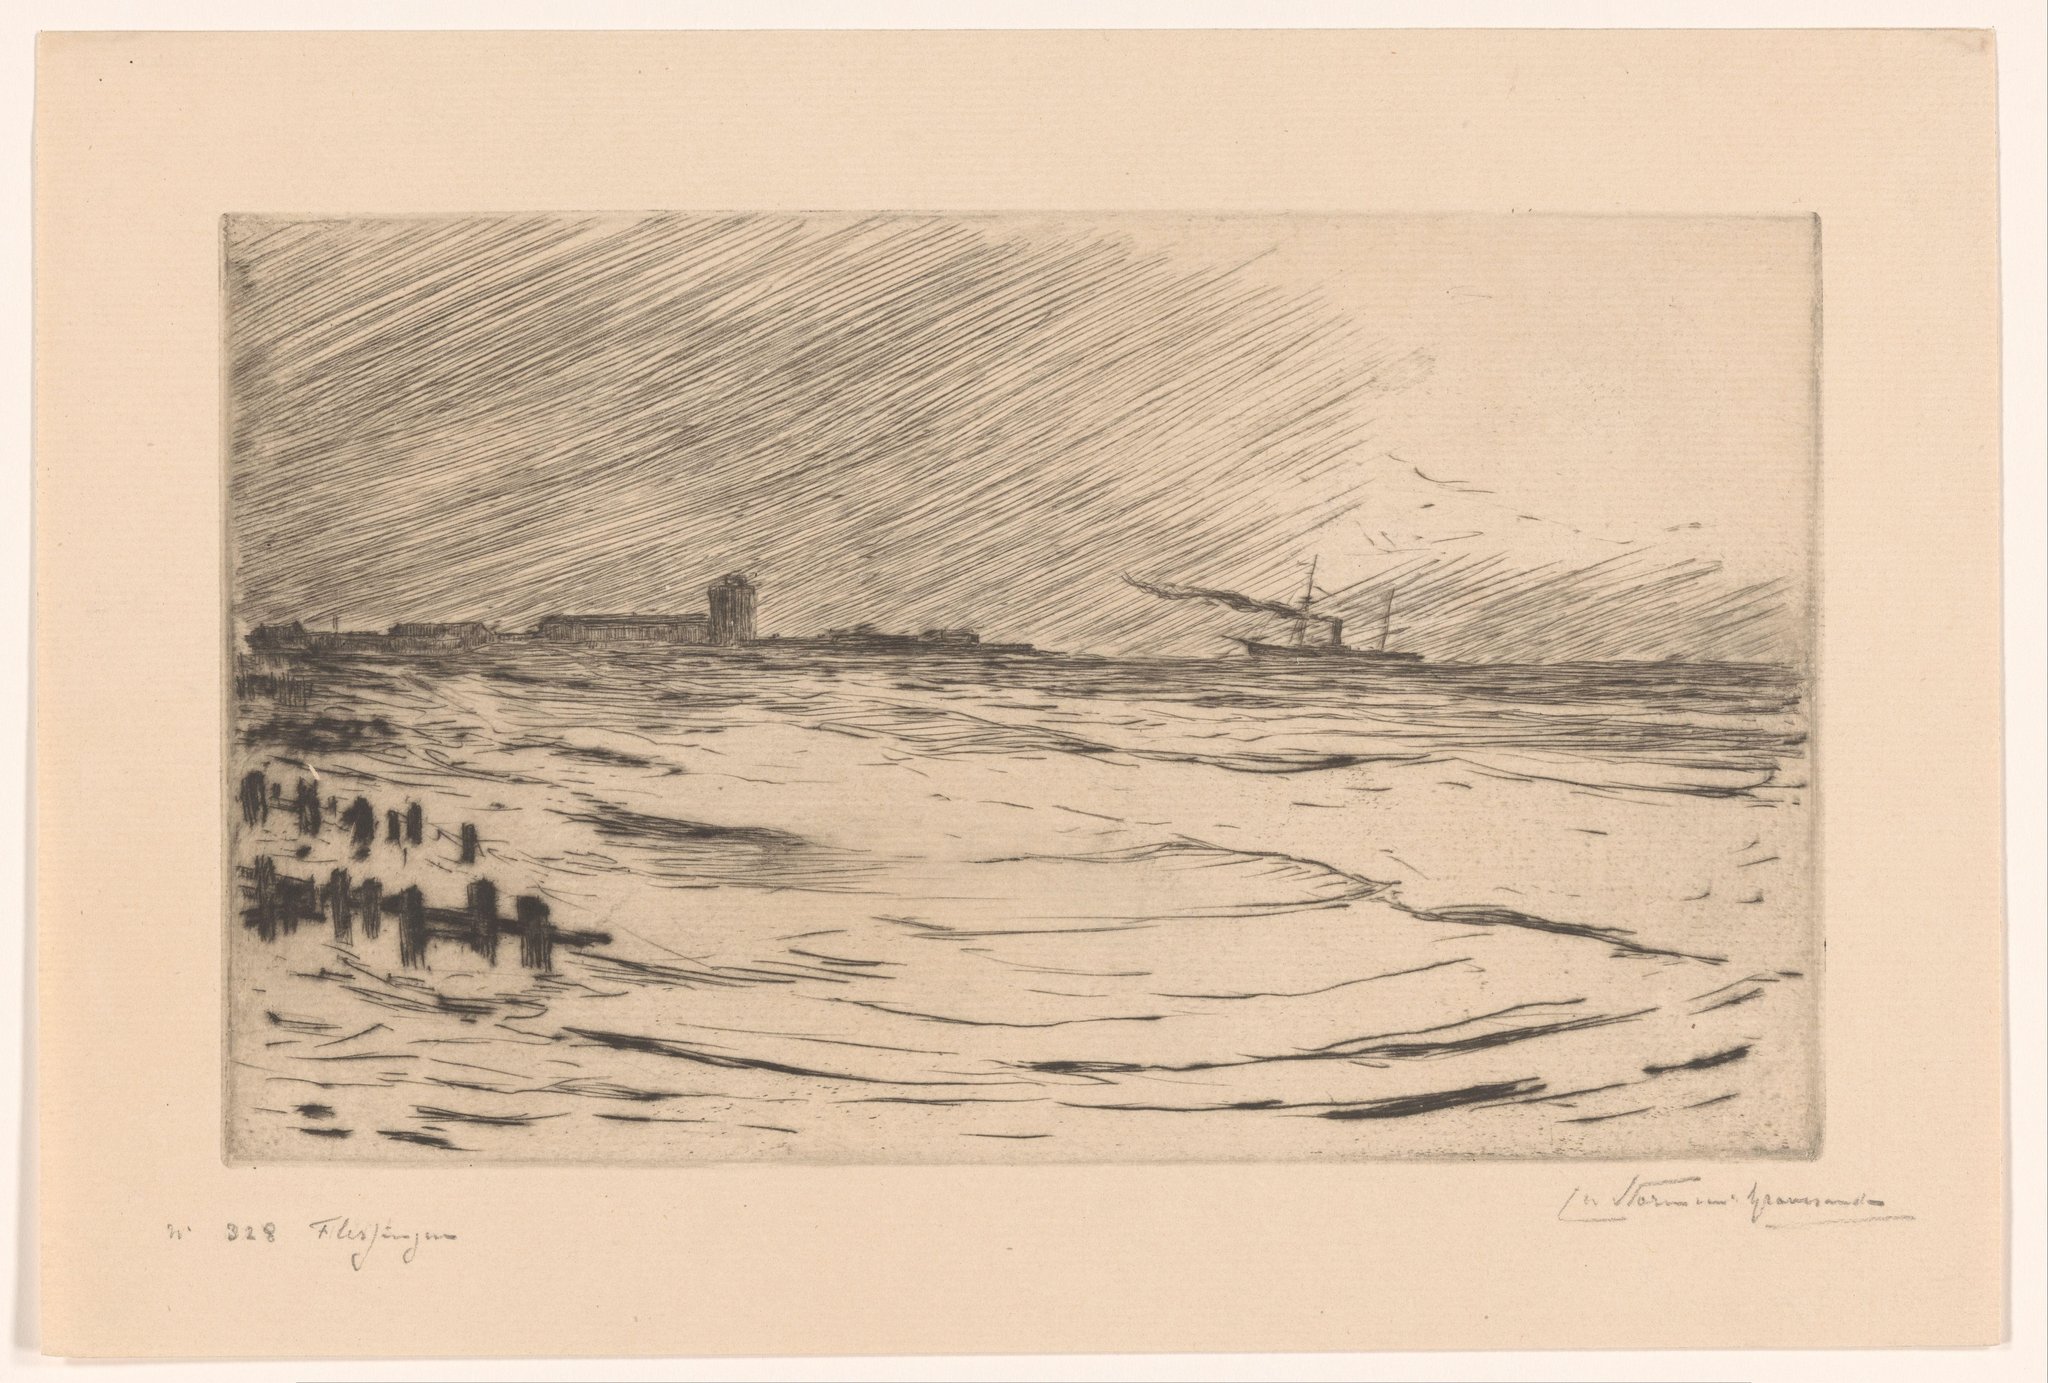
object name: print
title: Gezicht op Vlissingen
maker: carel nicolaas storm van s-gravesande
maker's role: draughtsman, print maker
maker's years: 1841-1924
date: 1889-1902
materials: paper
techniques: drypoint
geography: netherlands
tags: prospect of city, town panorama, silhouette of city, steamship, motorship, flushing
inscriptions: inscription: ‘Flisjingen’, number: ‘328’, collector's mark: Lugt 2228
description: Mogelijk vermeld in: Storm van 's-Gravesande, Charles. Catalogue des eaux-fortes et lithographies. New York: s.n., 1903, of in een onbekende latere uitgave van het manuscript. Vermoedelijk vermeld als catalogusnummer 328.